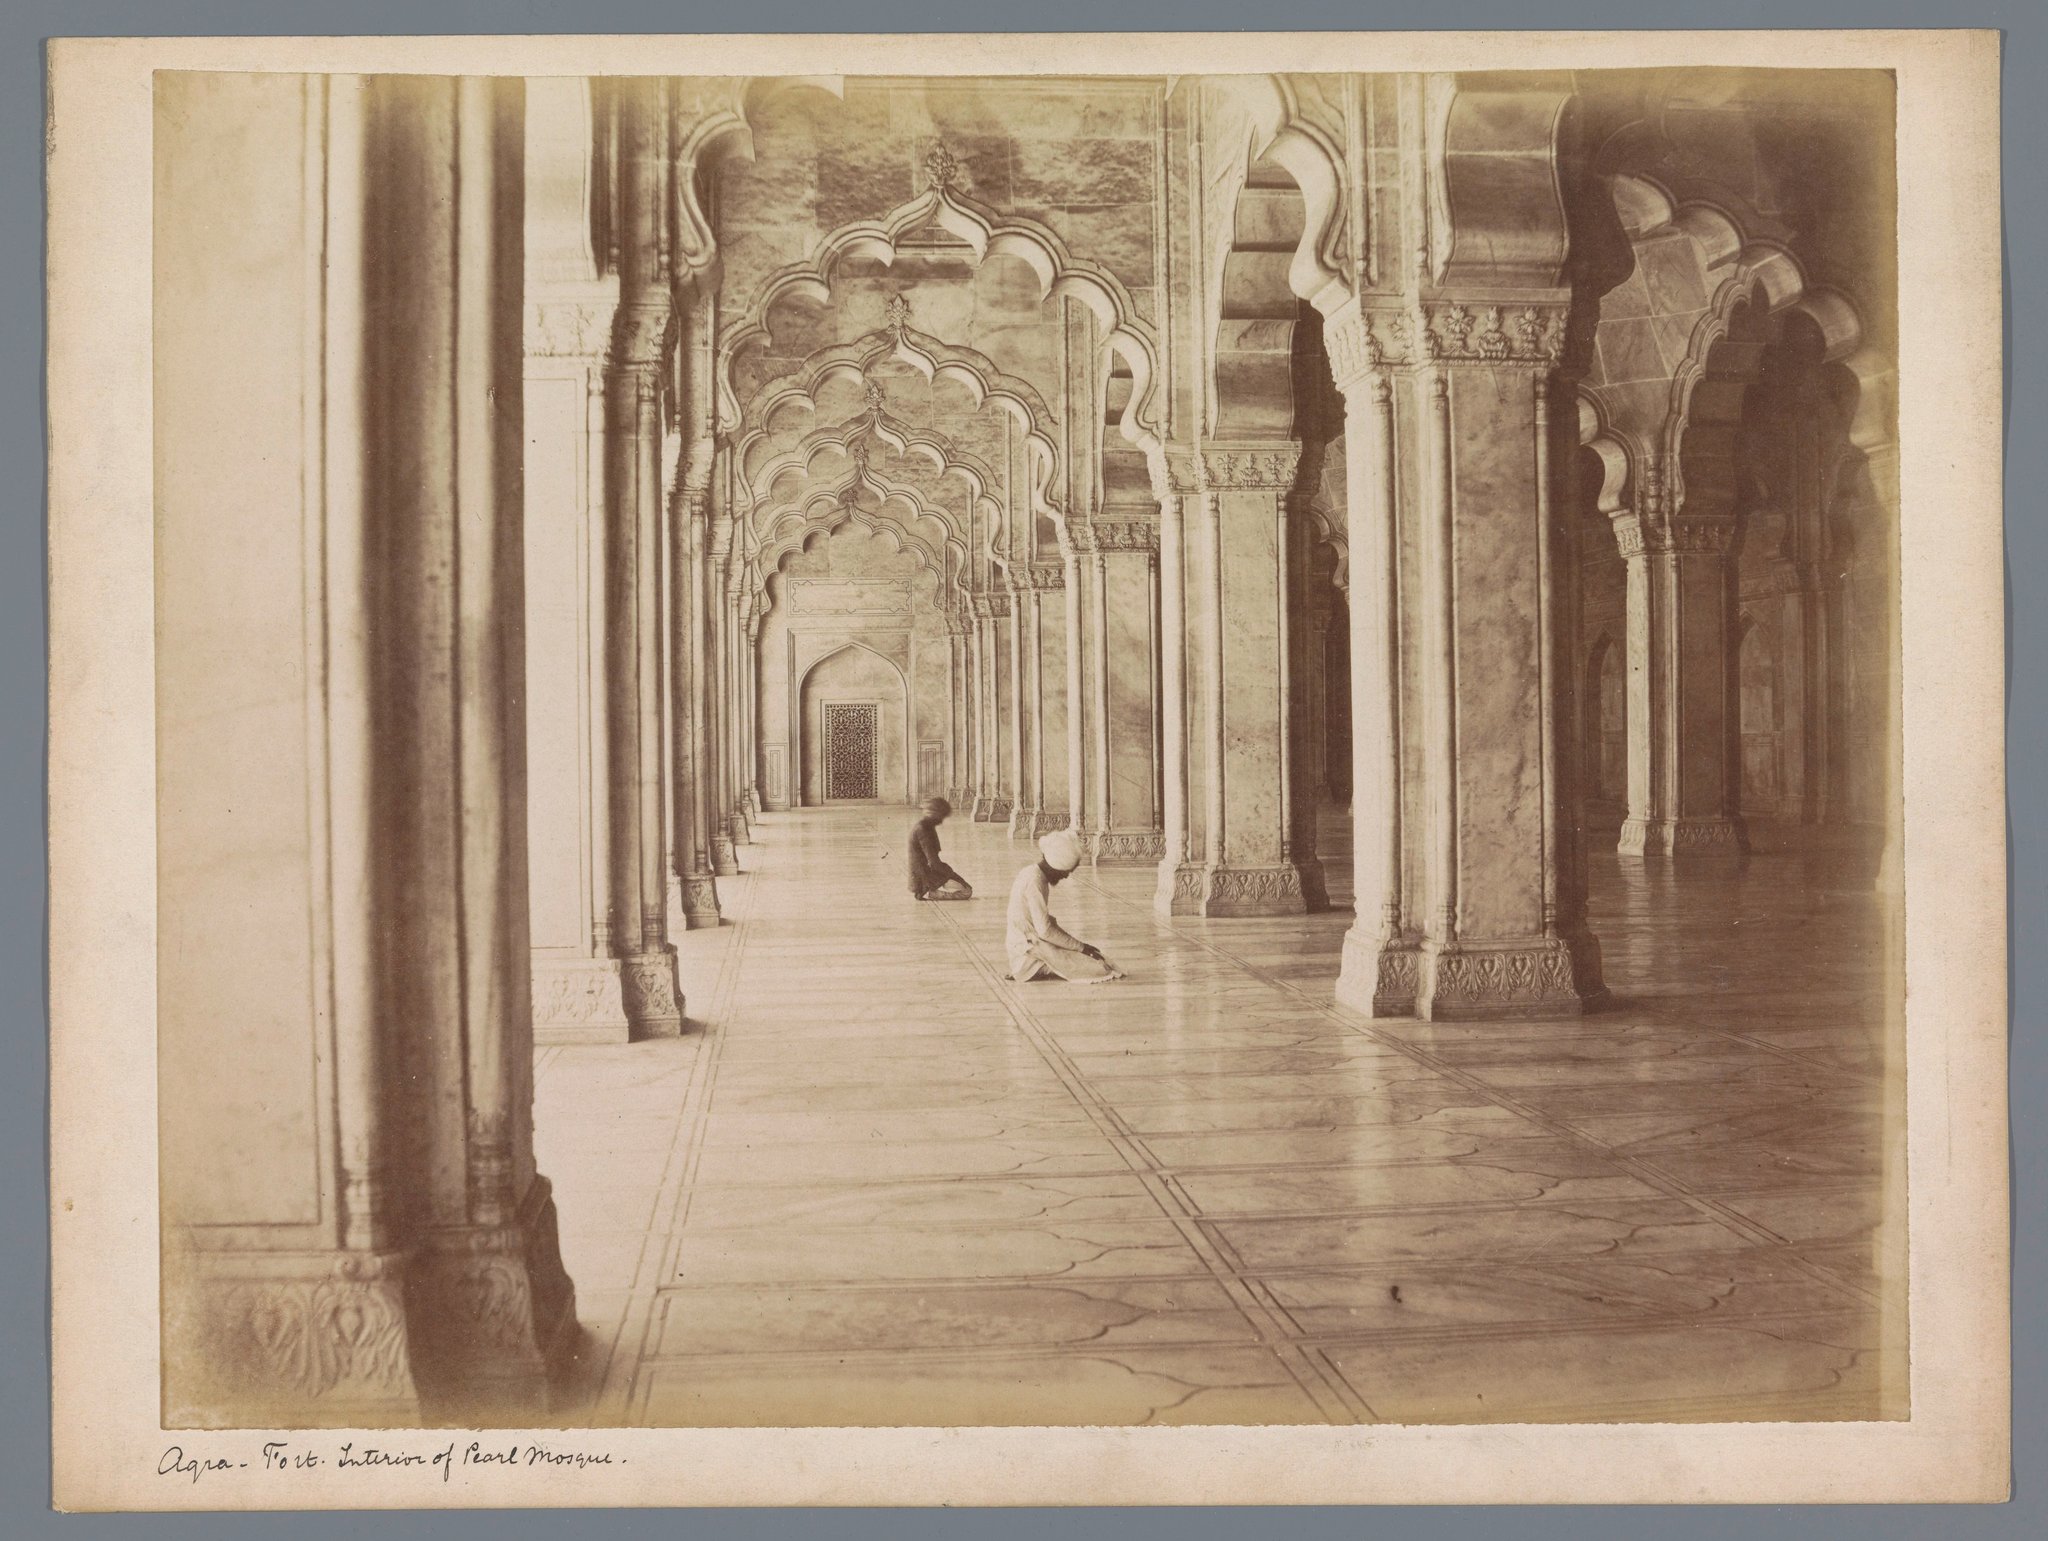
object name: photograph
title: Two praying men inside the Moti Masjid of Agra Fort, Uttar Pradesh, India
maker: samuel bourne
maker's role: fotograaf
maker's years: 1834-1912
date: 1863-1870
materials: cardboard, paper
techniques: albumen print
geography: agra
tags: temple, shrine ~ islam, mohammedanism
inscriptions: title: ‘Agra-Fort. Interior of Pearl Mosque.’, number: ‘42’